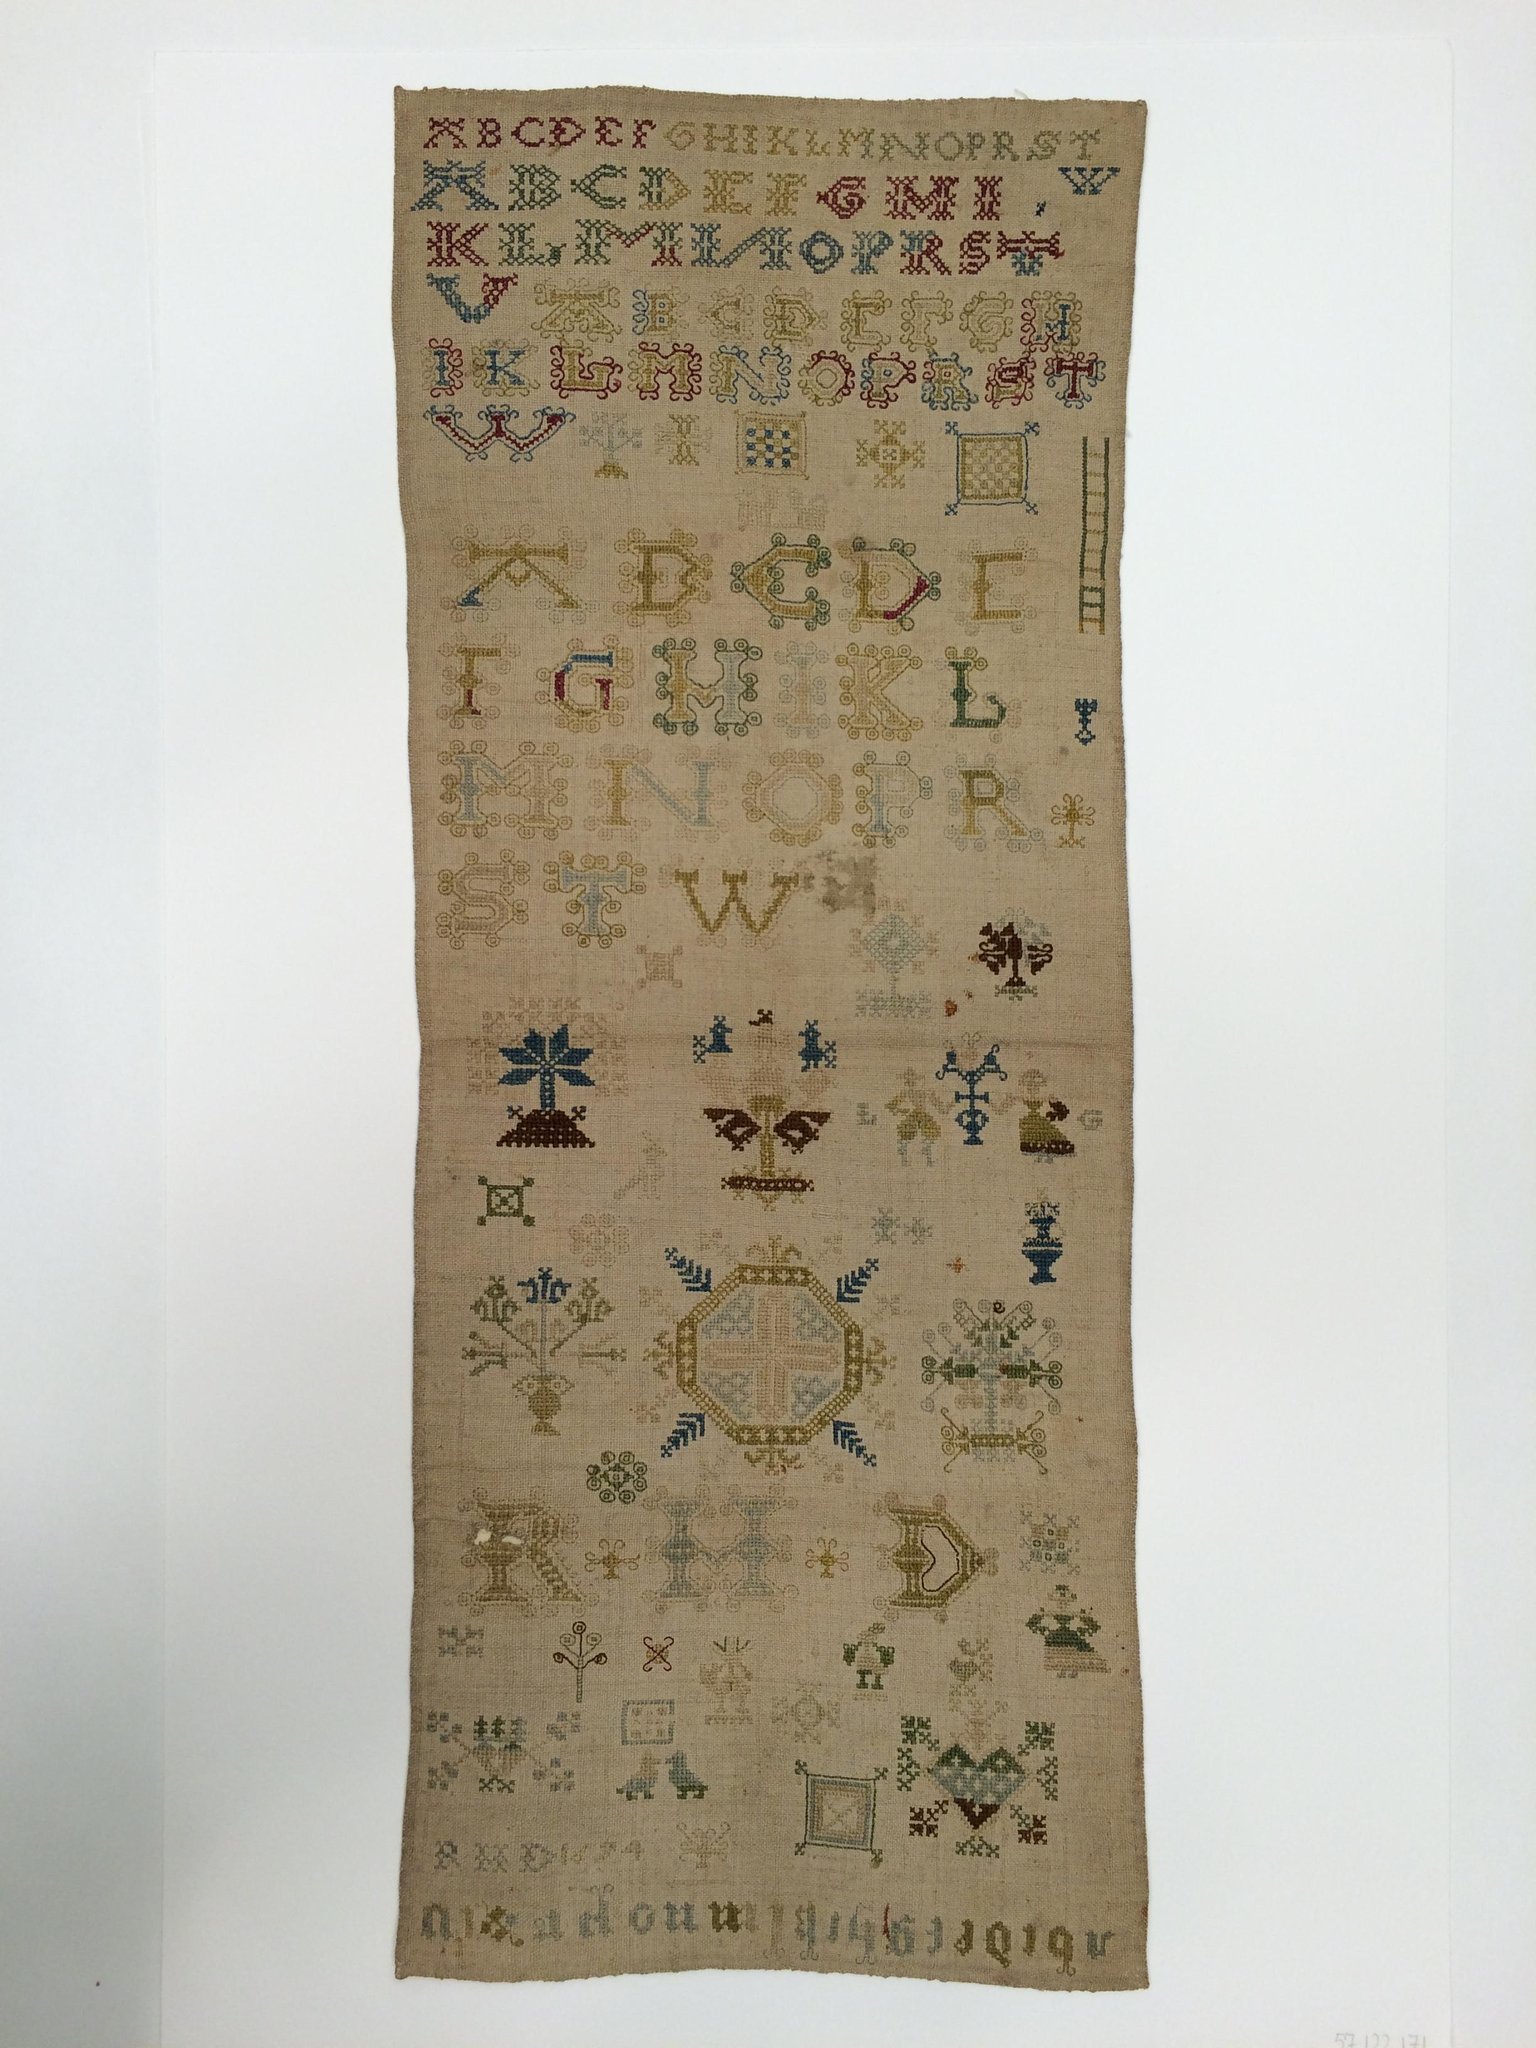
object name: sampler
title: Embroidered sampler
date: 1674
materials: linen, silk